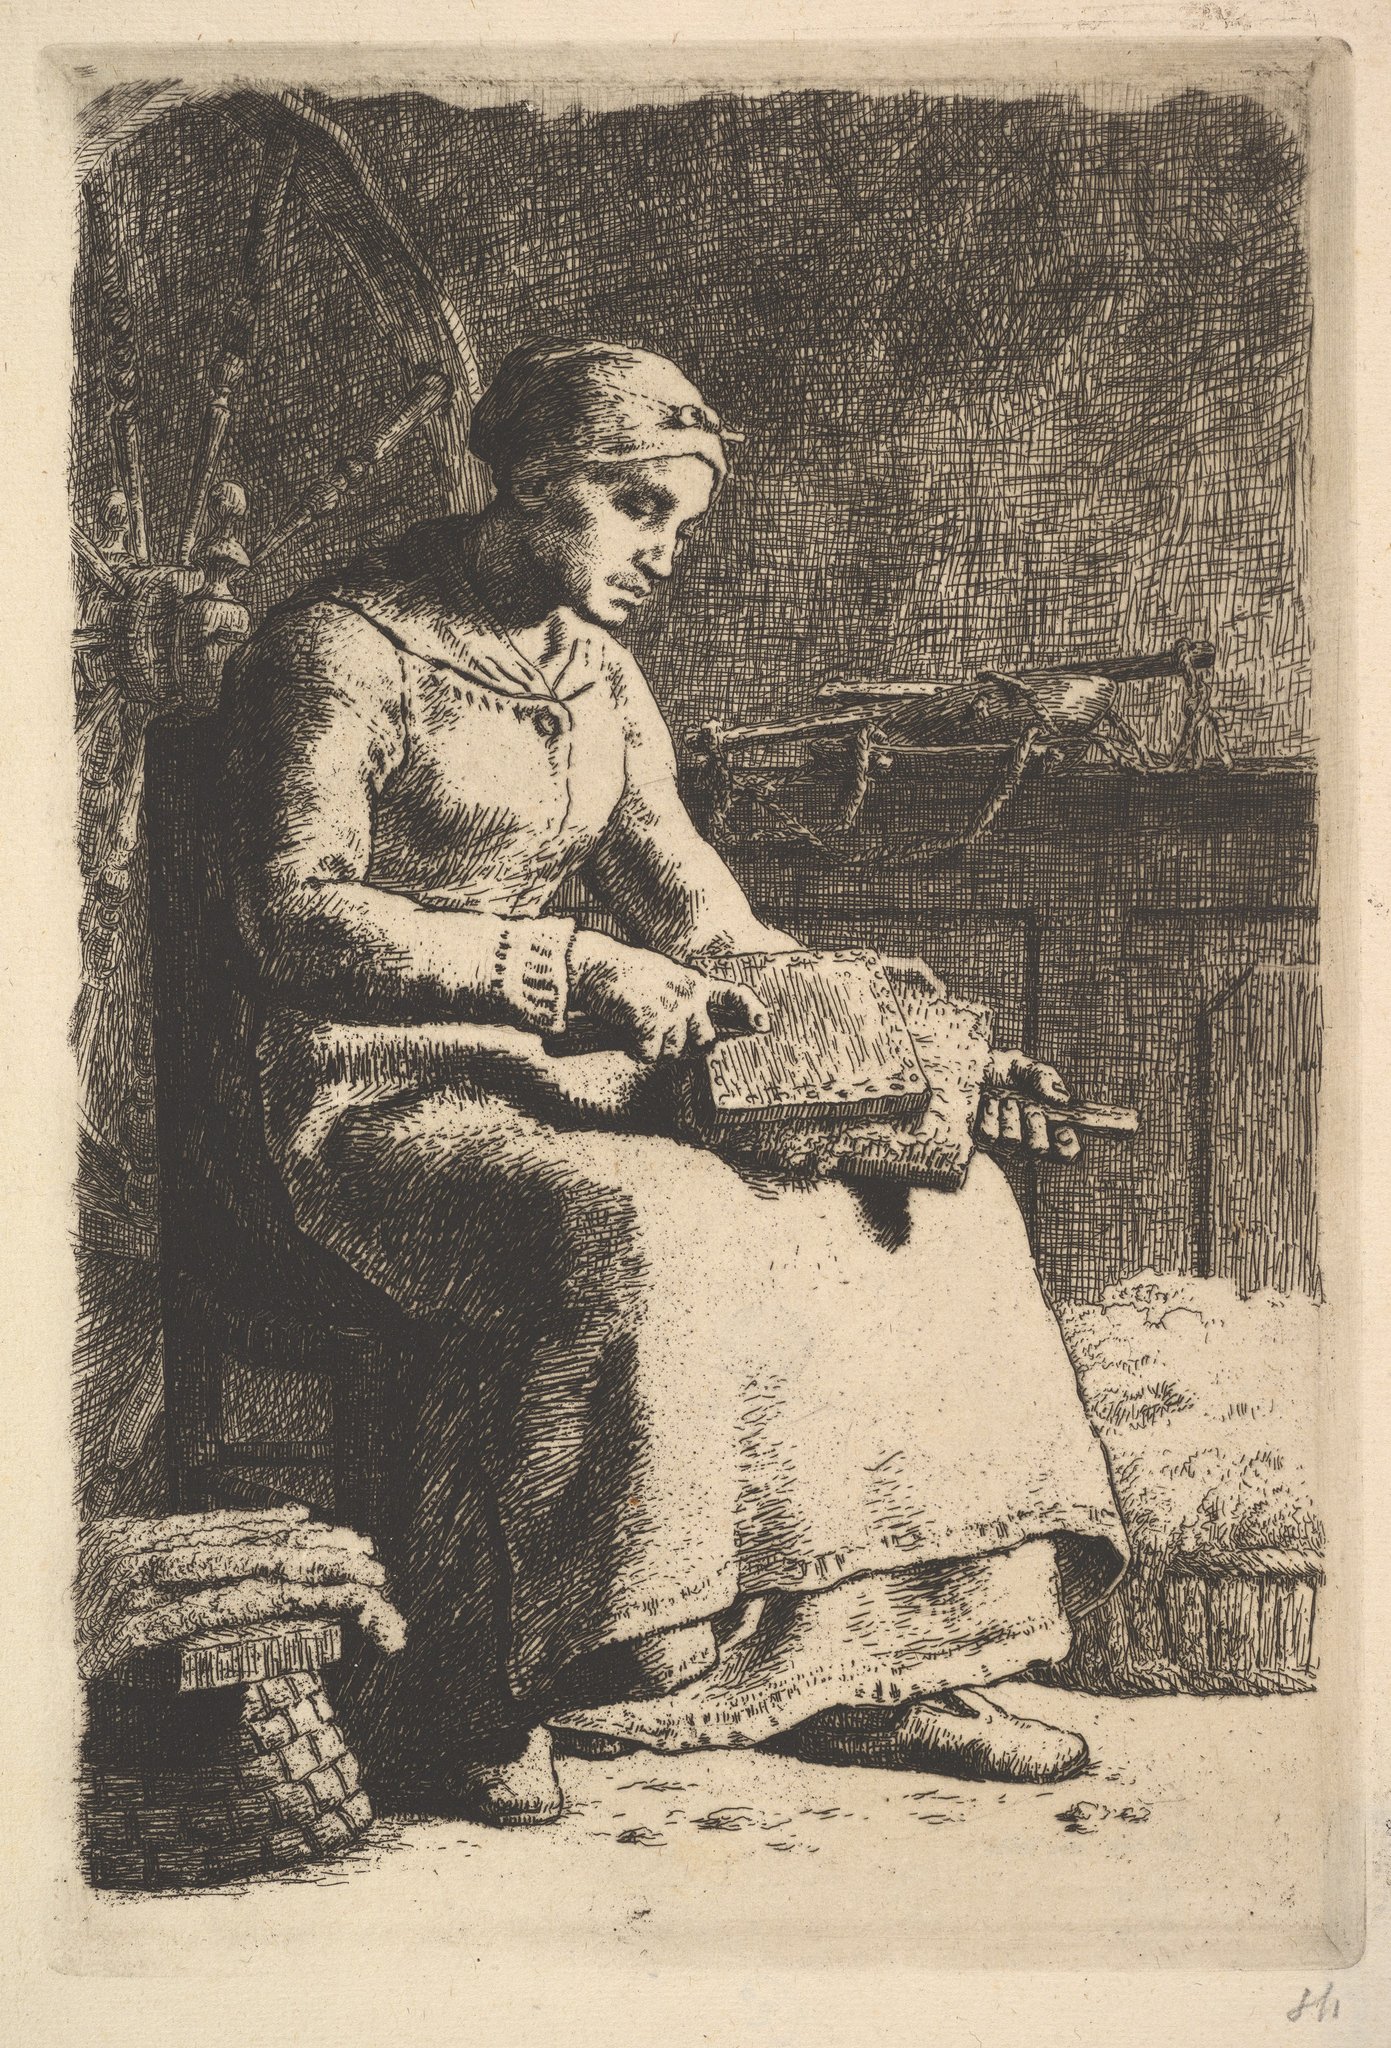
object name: print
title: The Wool Carder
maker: jean-françois millet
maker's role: artist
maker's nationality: french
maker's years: 1814-1875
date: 1855-1856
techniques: etching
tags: women,working